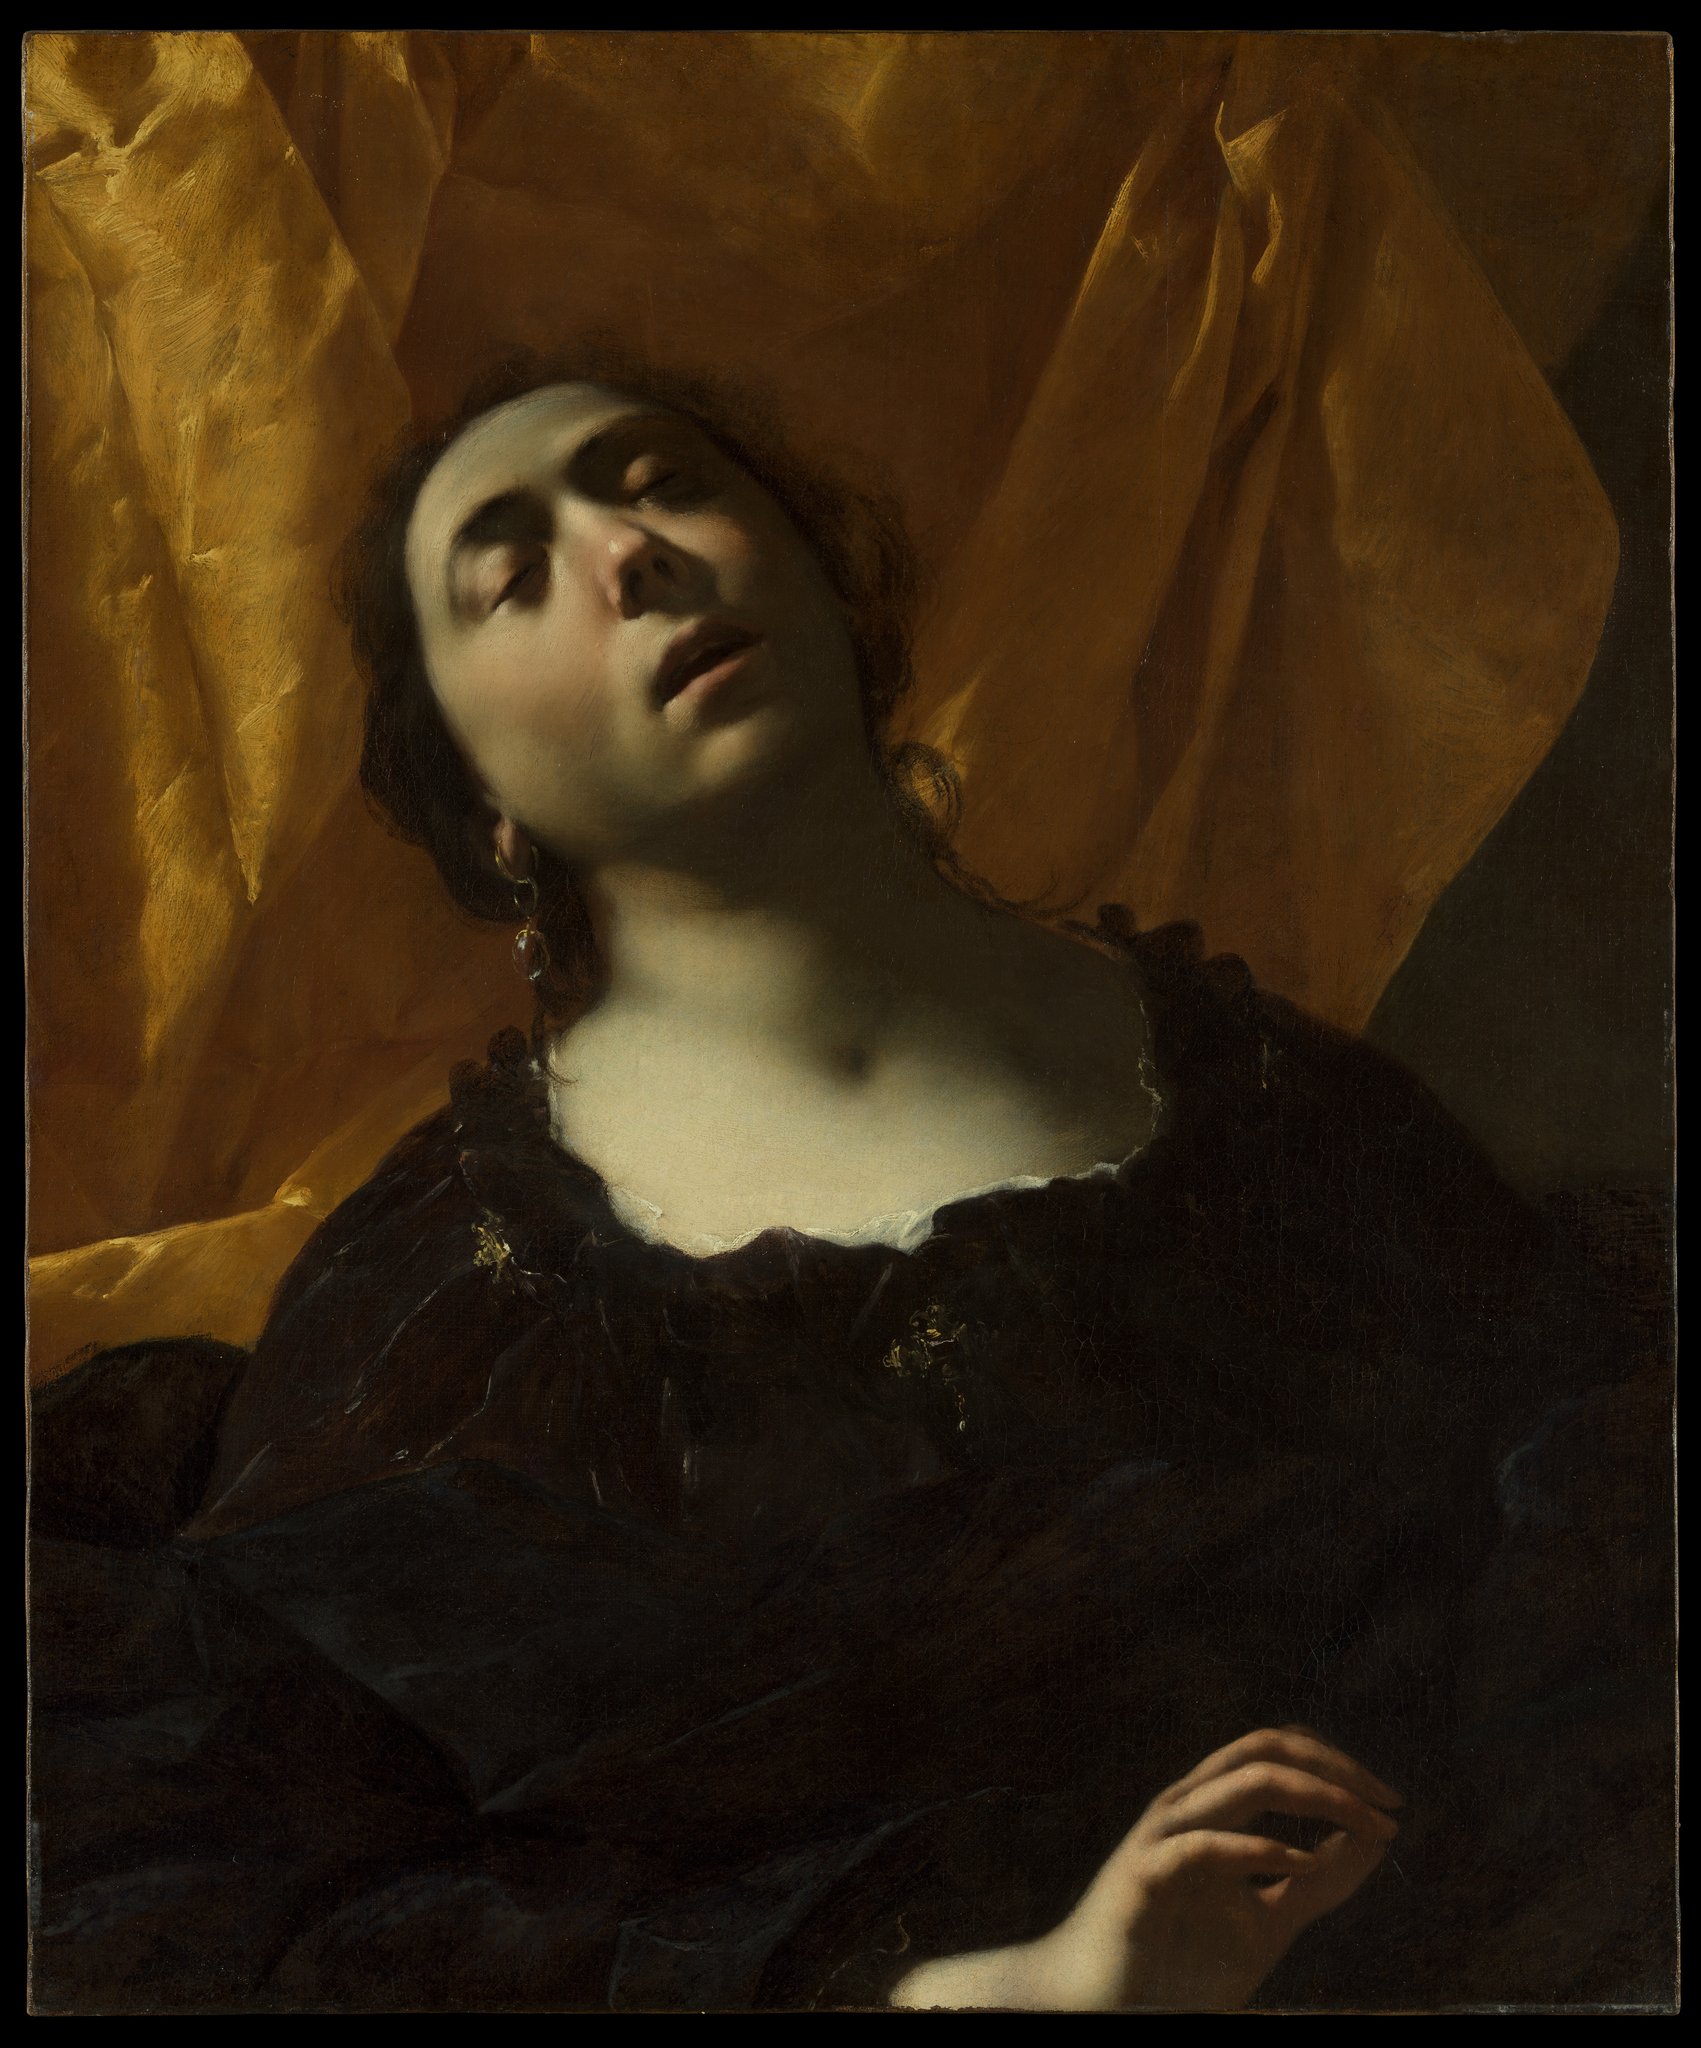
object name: painting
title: Herodias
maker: francesco cairo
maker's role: artist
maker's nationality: italian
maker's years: 1607-1665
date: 1635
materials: canvas, oil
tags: women